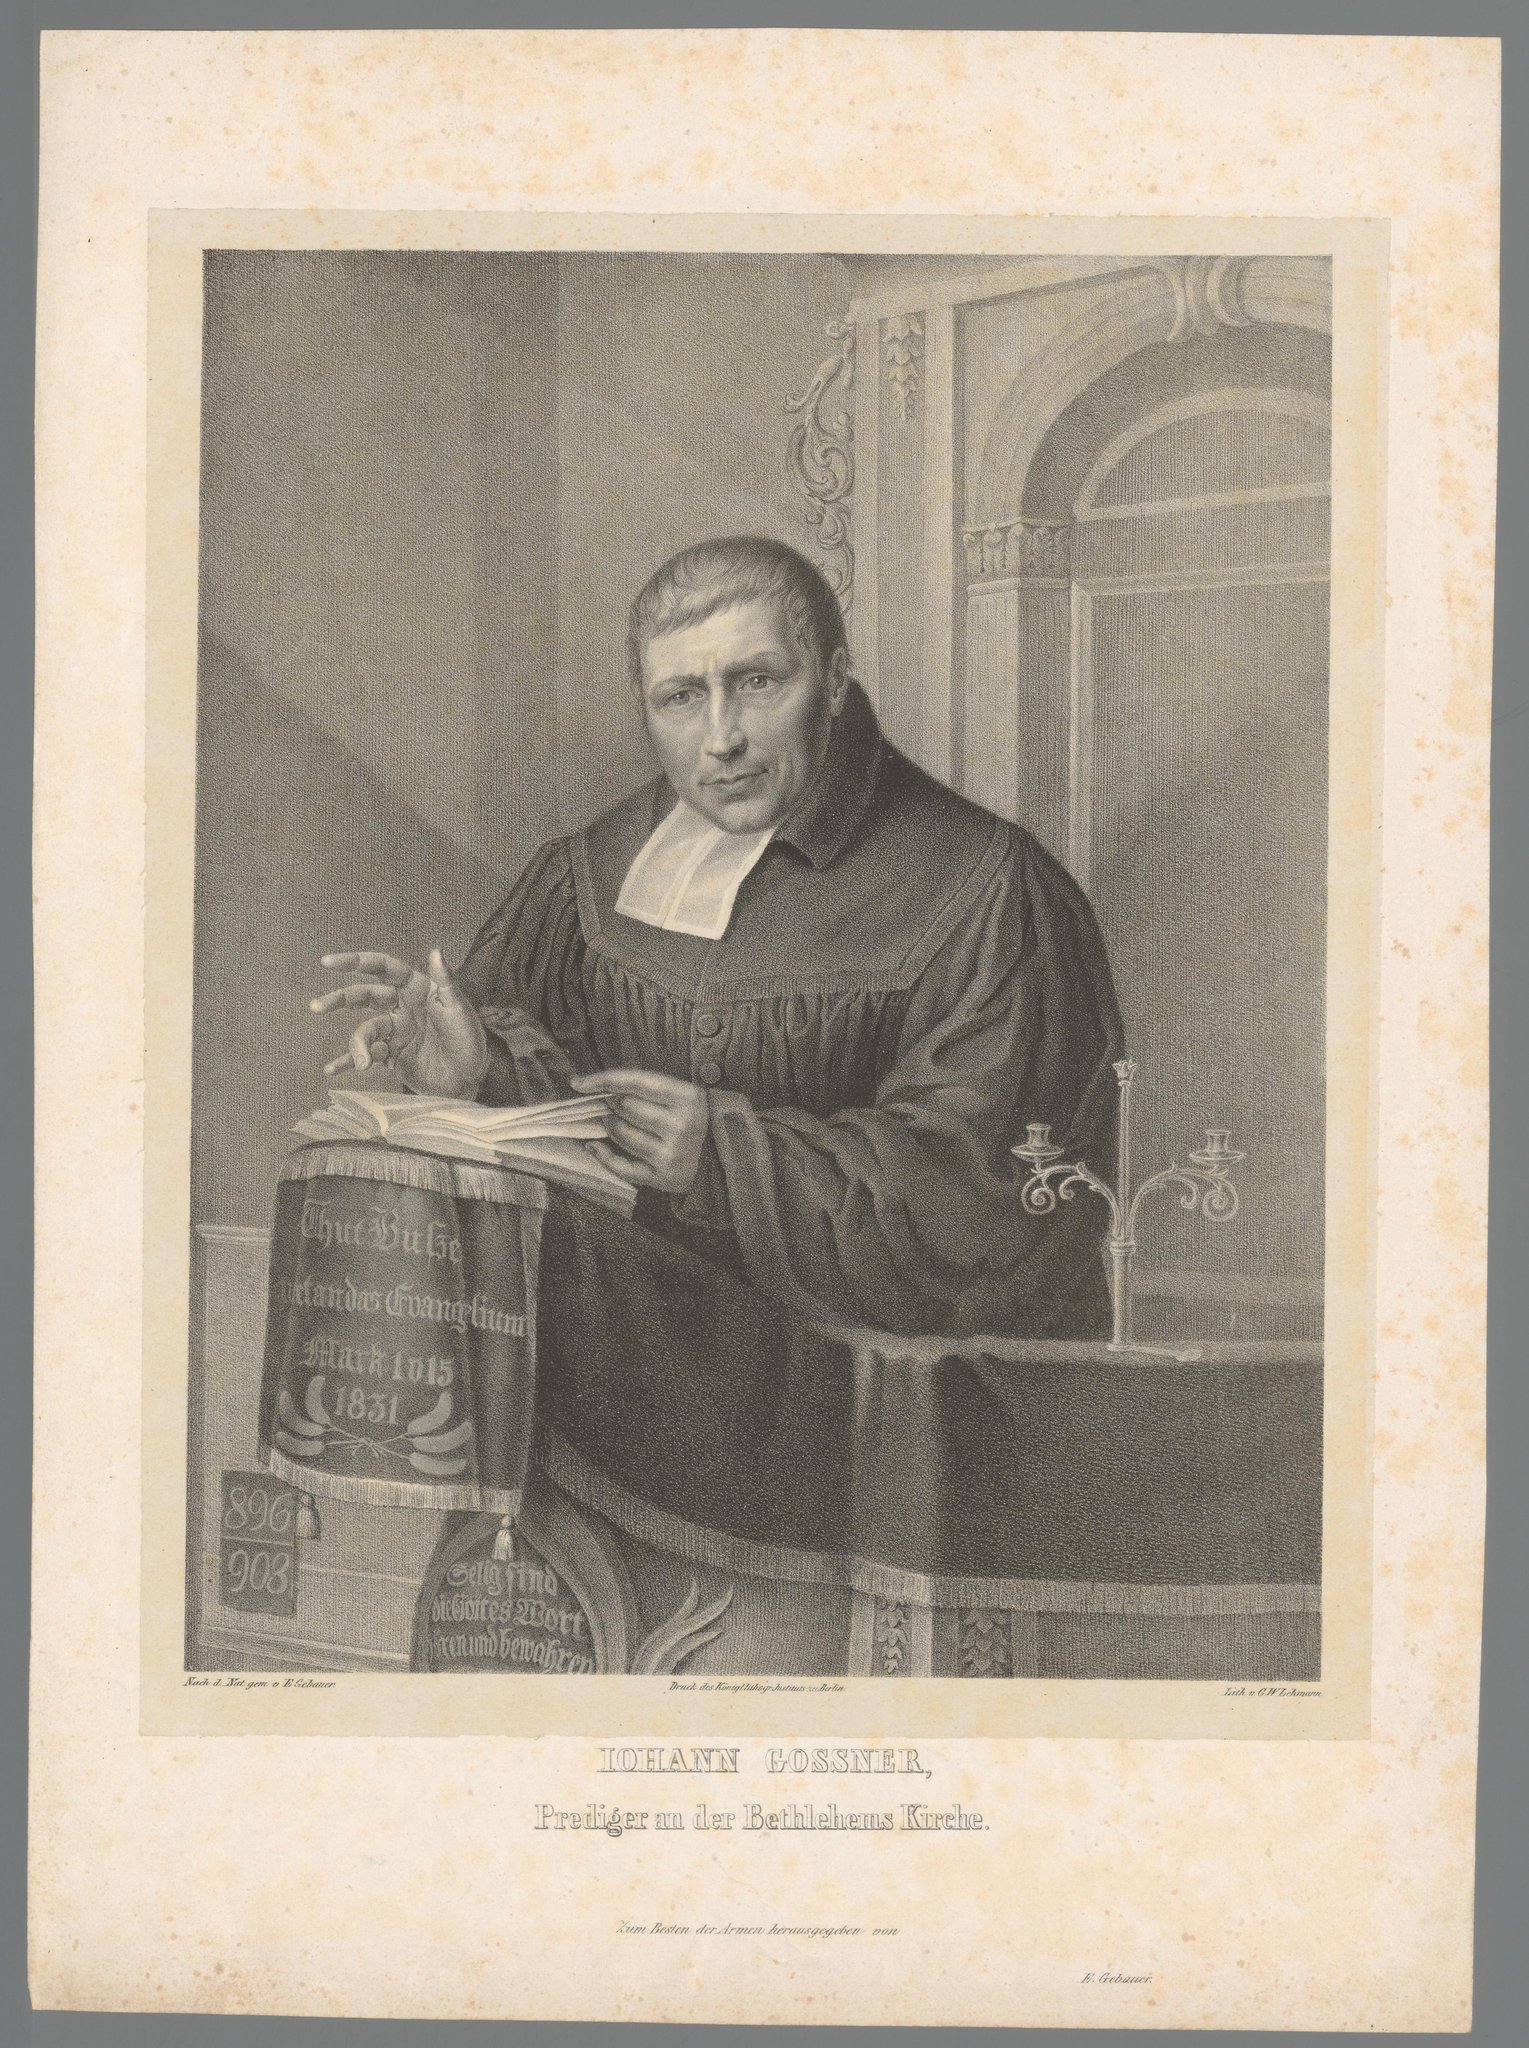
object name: print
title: Portret van Johann Gossner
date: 1792-1865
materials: paper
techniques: lithograph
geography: berlin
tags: berlin, hierarchy of jurisdiction ~ roman catholic church, historical persons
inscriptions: collector's mark: Lugt 2228